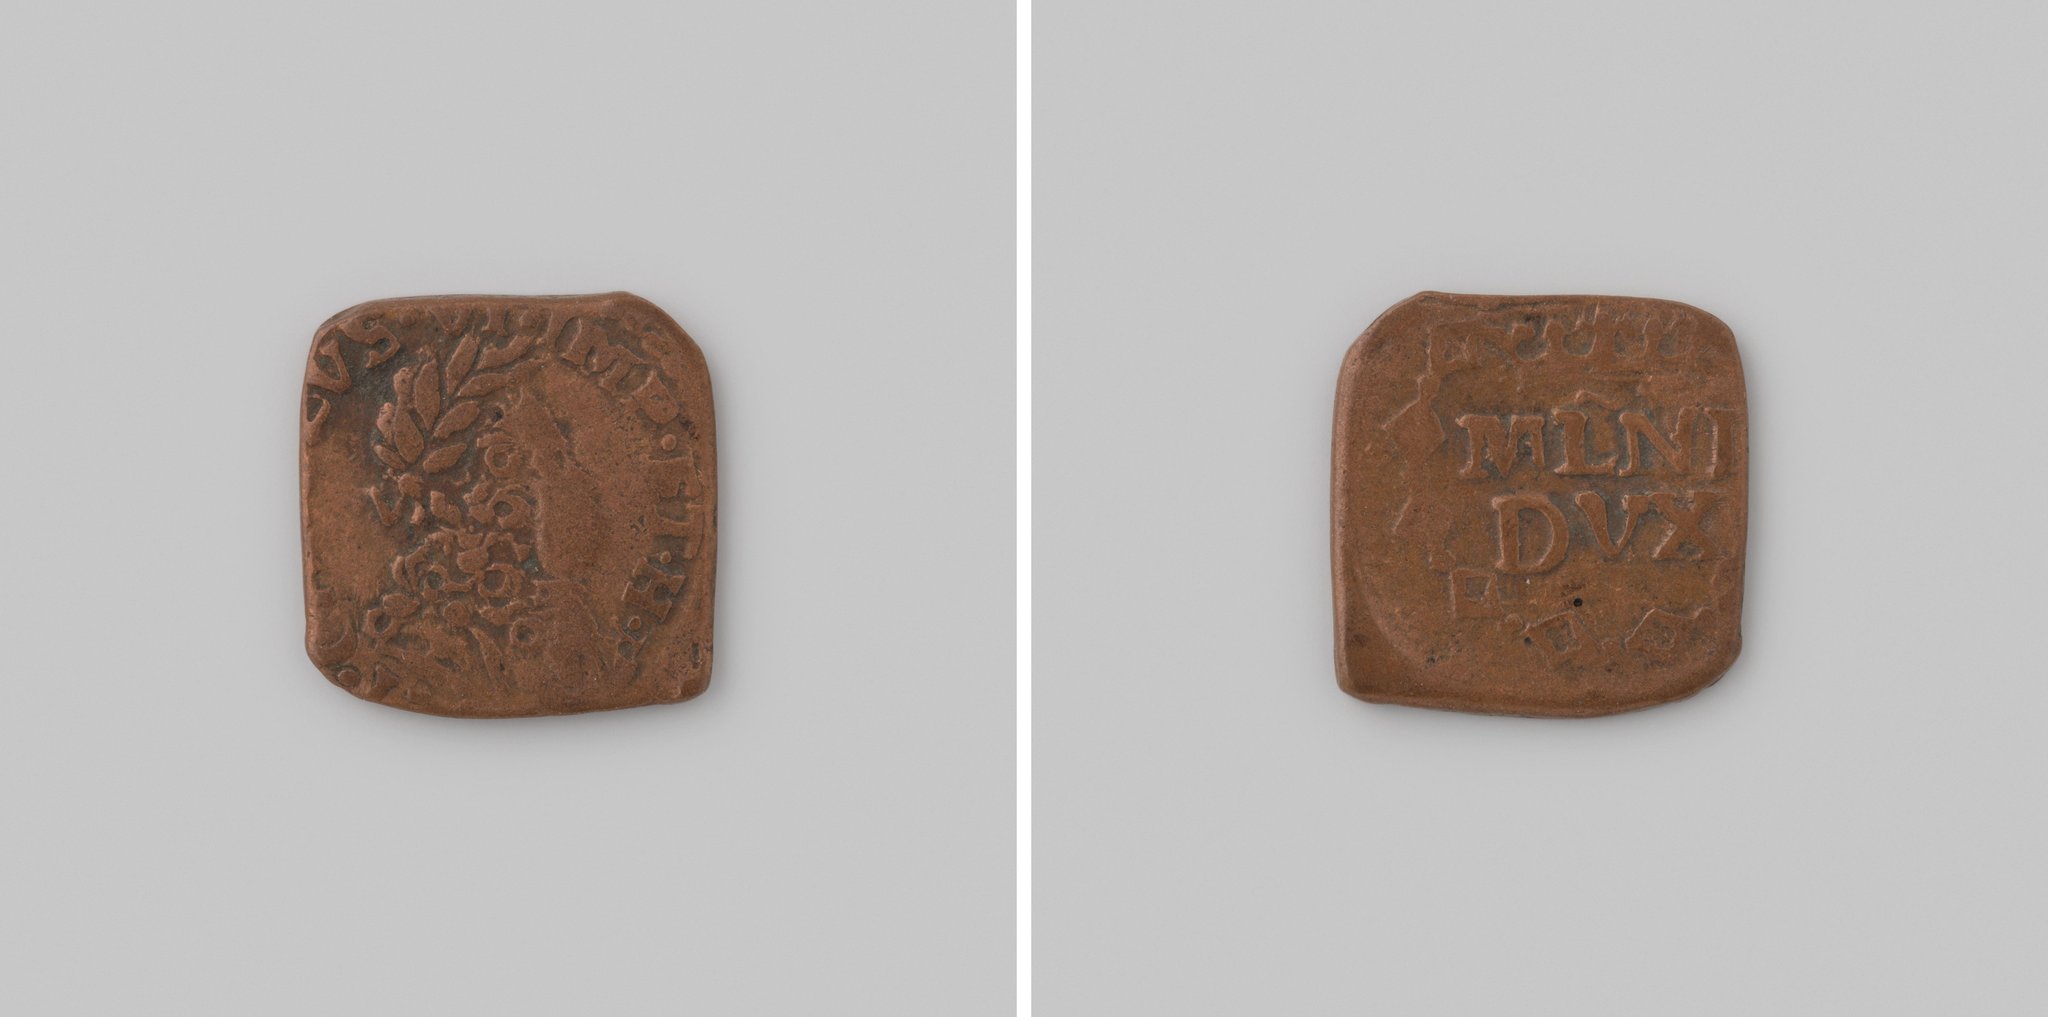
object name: coin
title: Quattrino uit Milaan van keizer Karel VI als hertog, 1736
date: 1736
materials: copper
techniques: striking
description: Vierkante koperen munt. Voorzijde: gelauwerd portret van Karel VI naar rechts. Keerzijde: tussen schakels van ketting kroon, waaronder in twee regels plaats-aanduiding.